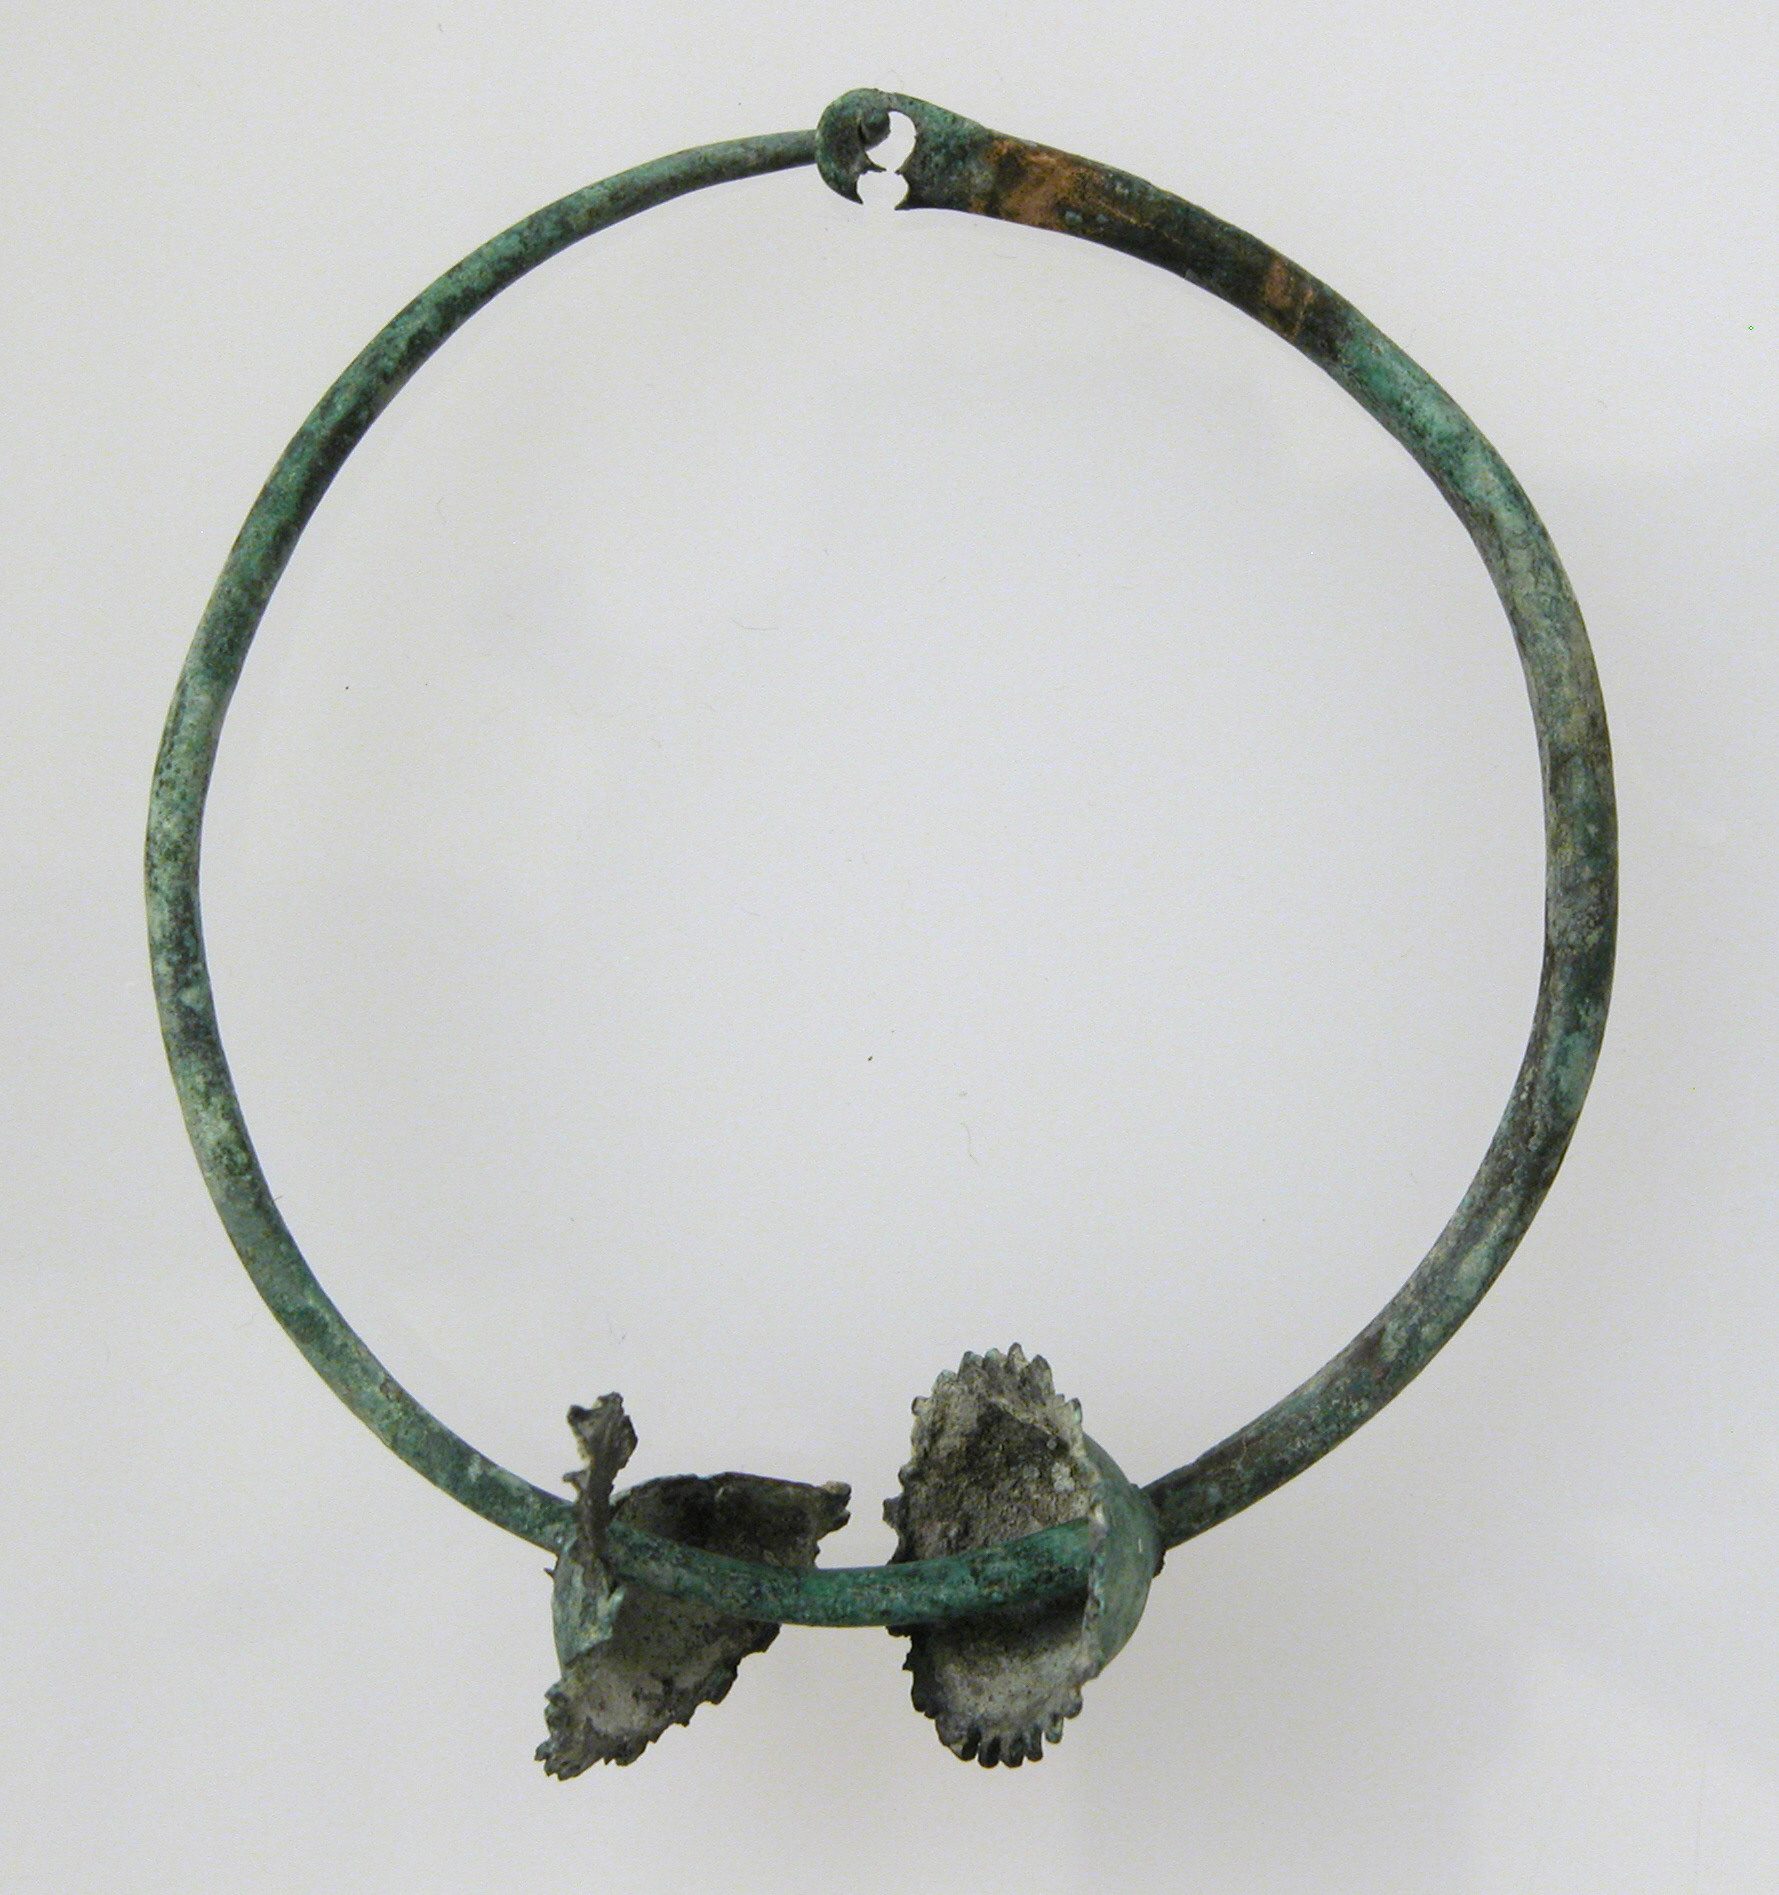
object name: earring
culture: roman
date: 301-400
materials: copper alloy